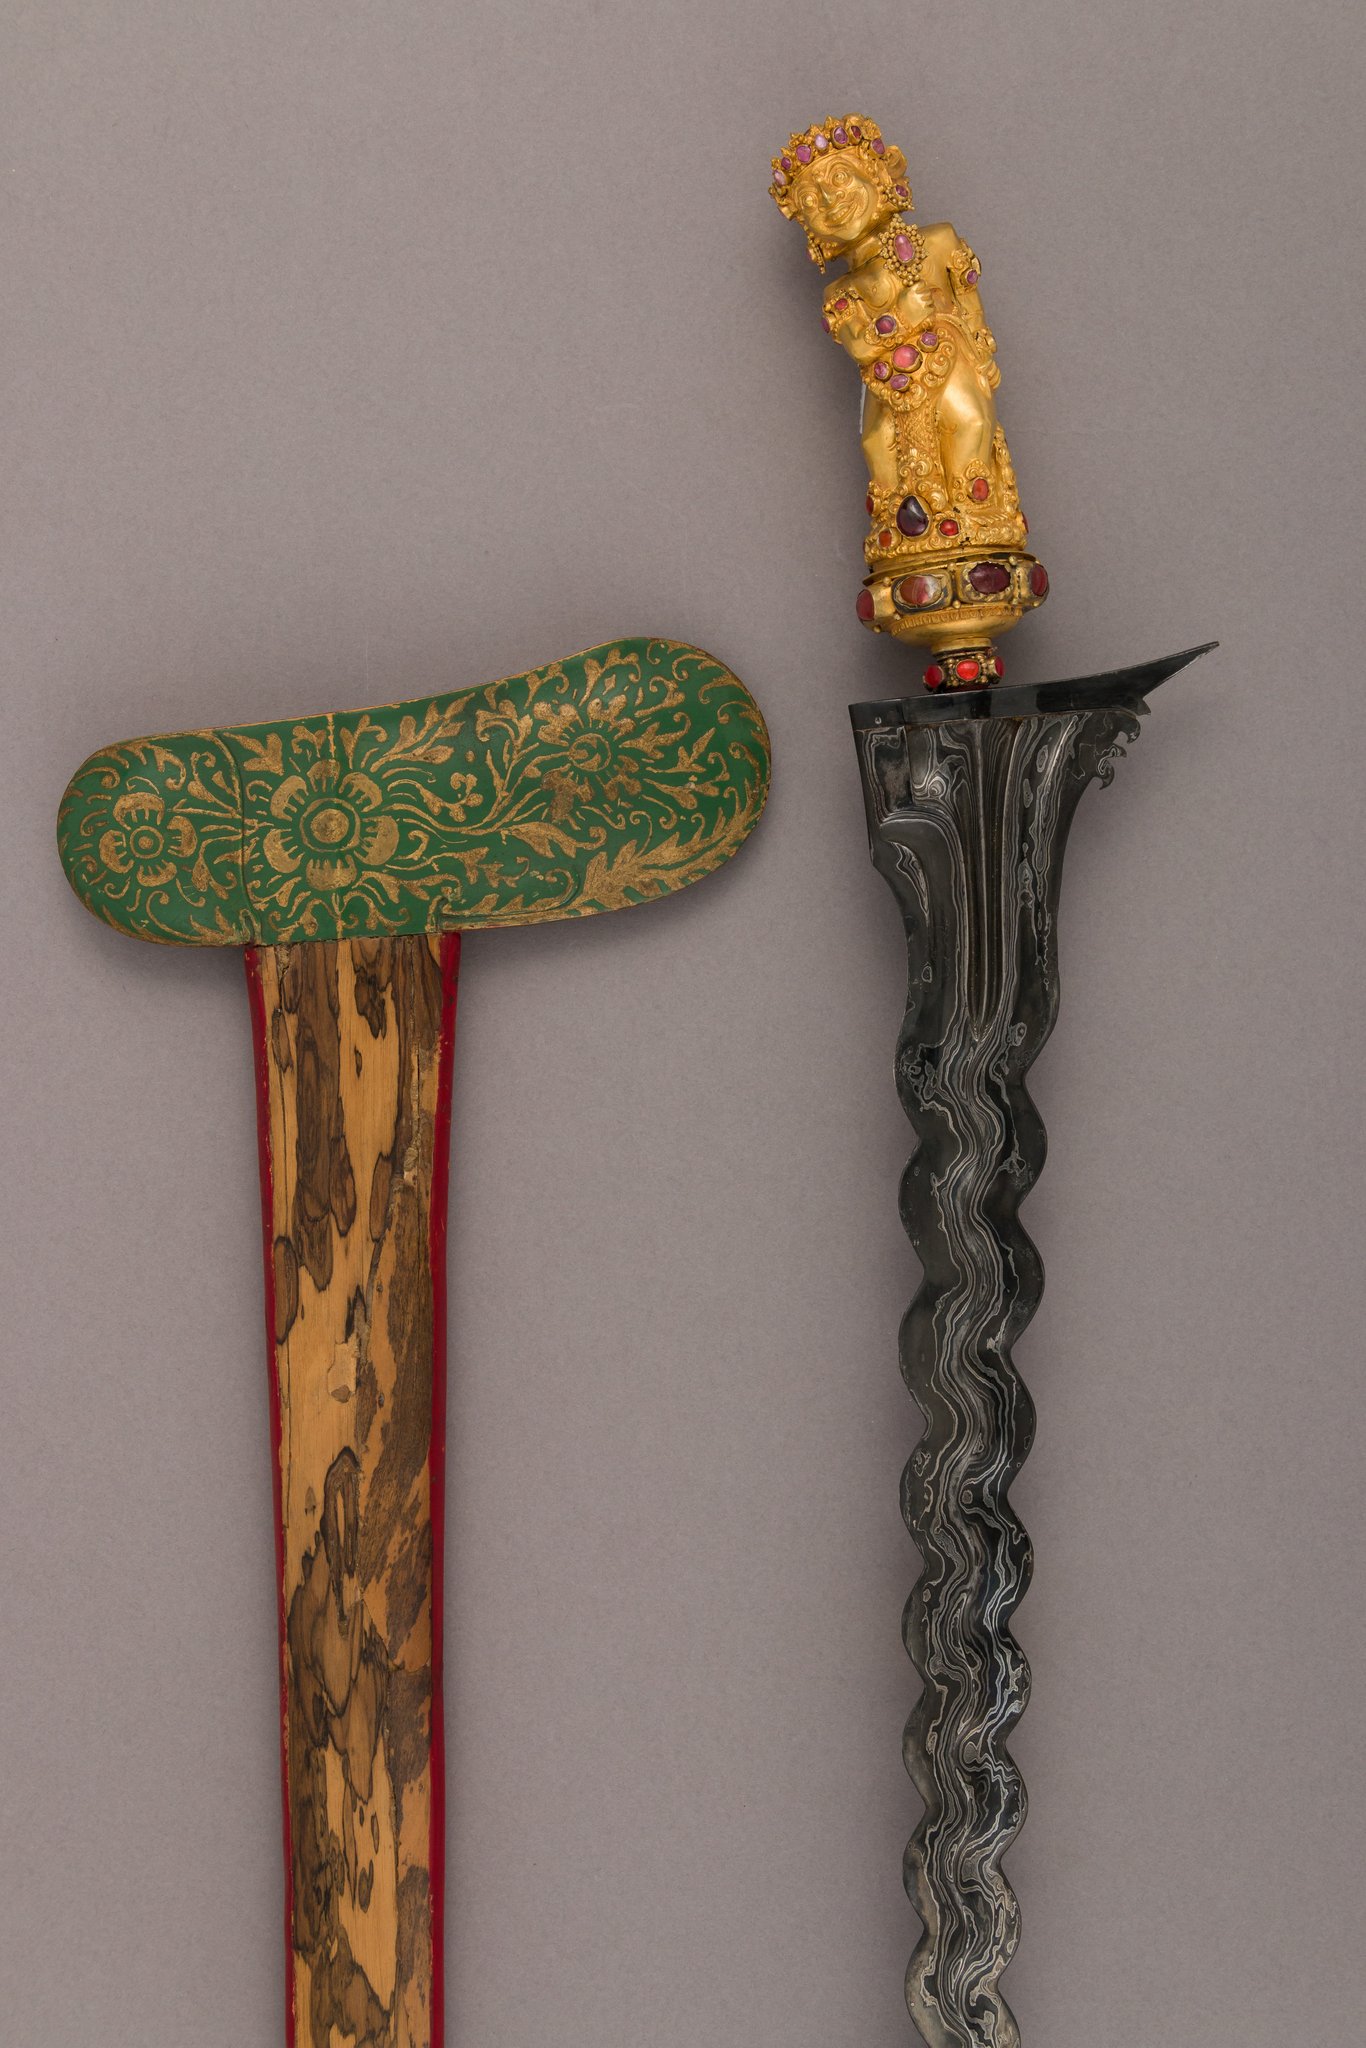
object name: kris with sheath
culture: balinese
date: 1801-1900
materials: gold, steel, stone, wood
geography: indonesia